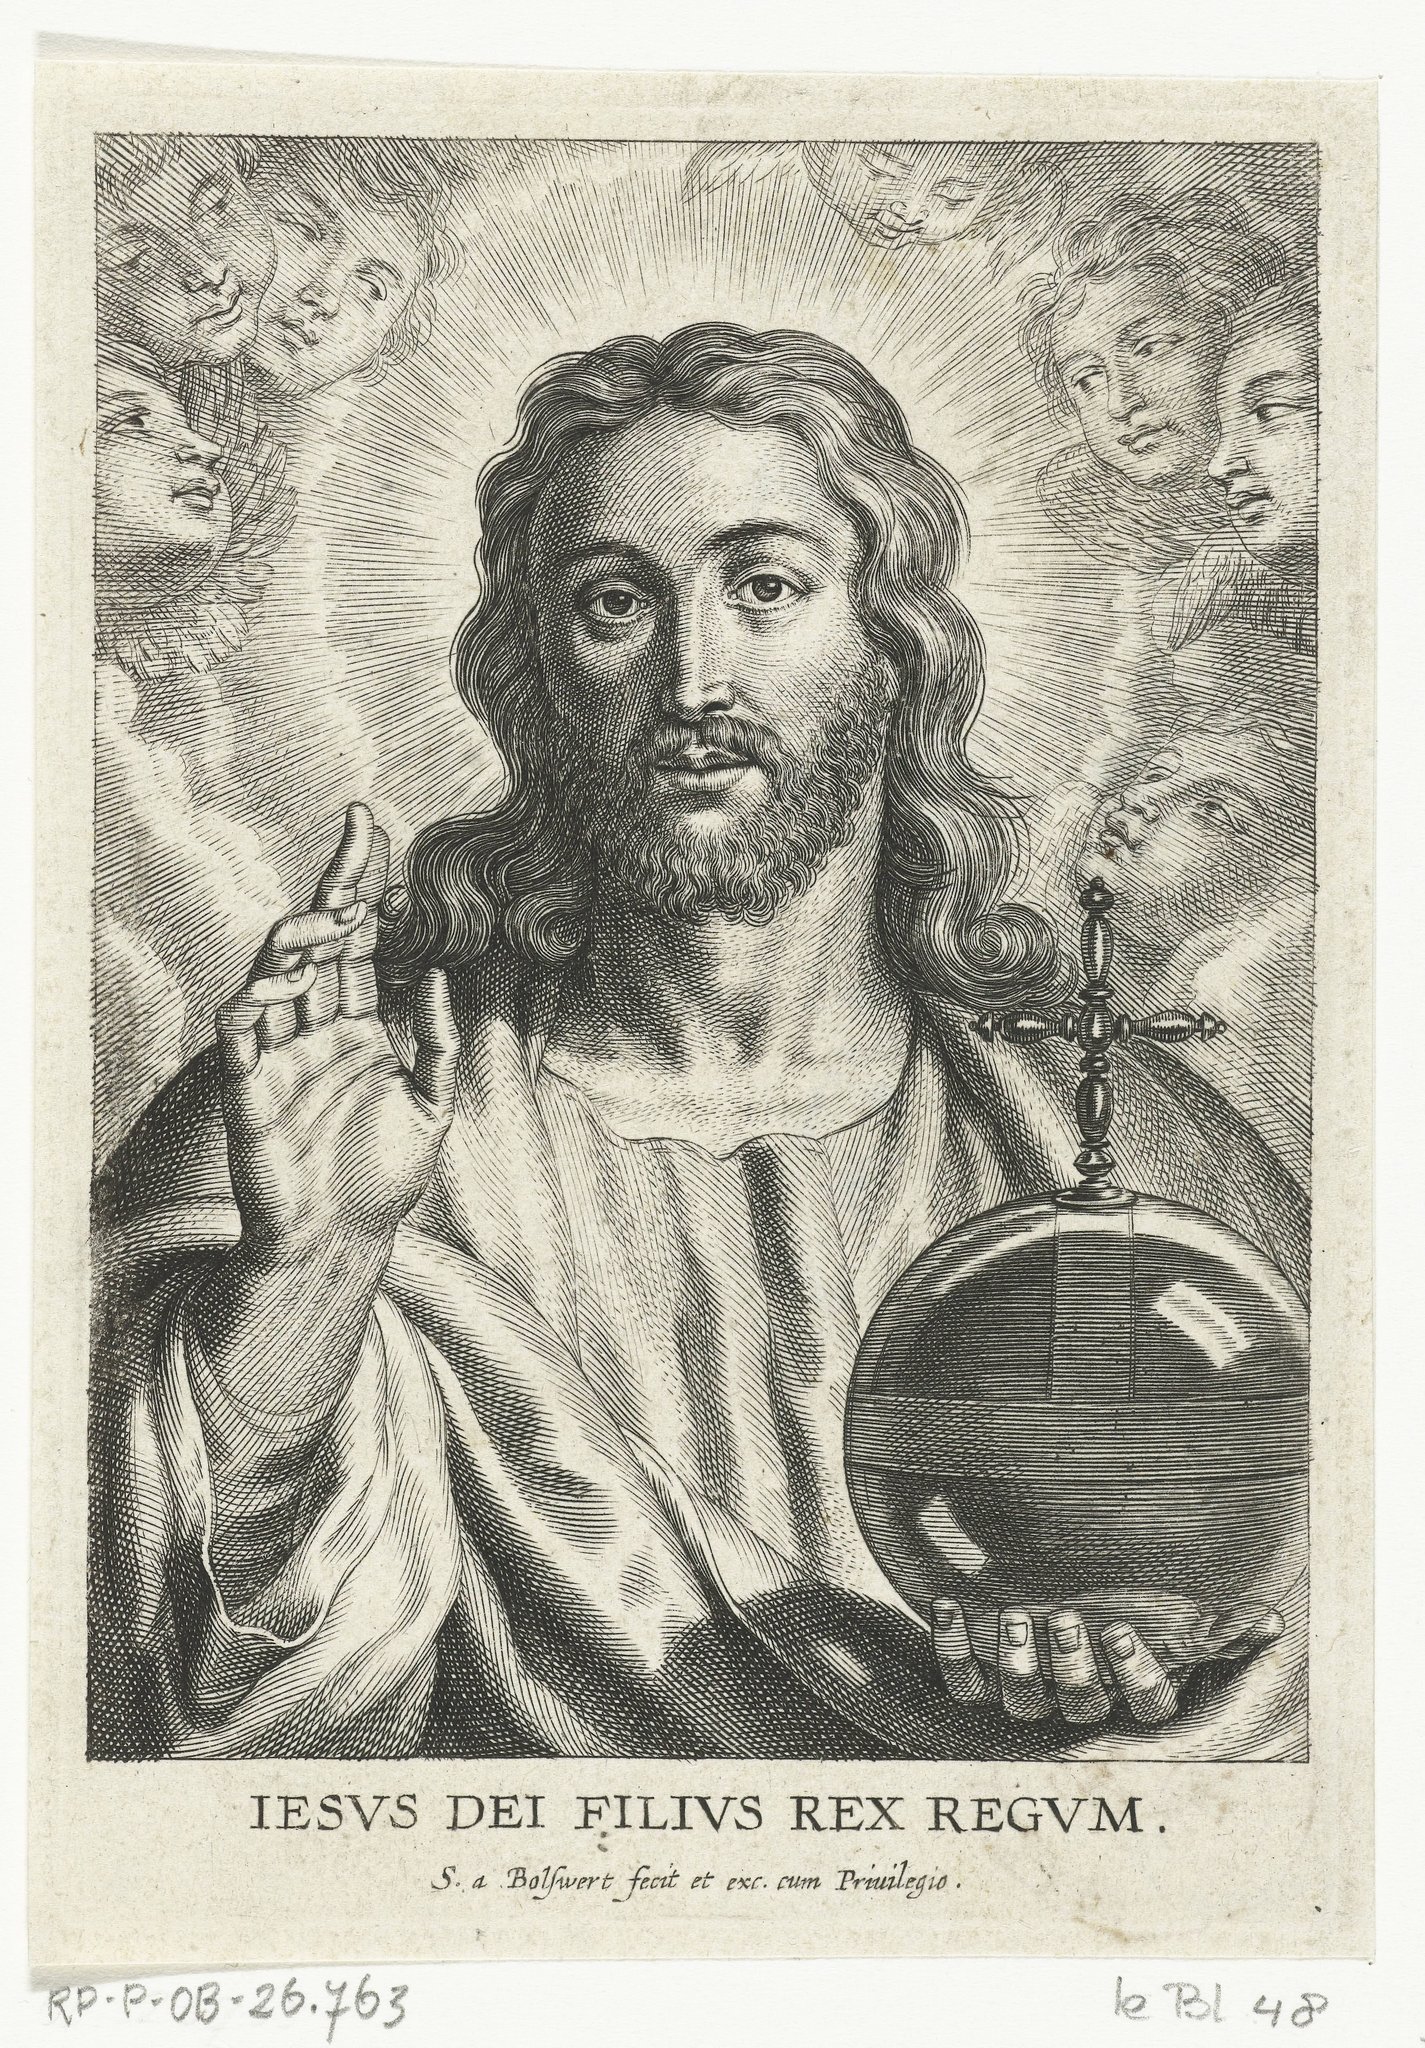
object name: print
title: Christus als Salvator Mundi met cherubijnen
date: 1596-1659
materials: paper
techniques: engraving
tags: 'salvator mundi', making a blessing gesture; an orb in his hand or at his feet (+ angel(s))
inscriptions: collector's mark: Lugt 240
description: Prent uit serie Vélins met negentig prenten naar ontwerp van Peter Paul Rubens. In de bronnen vinden we uiteenlopende gegevens over aantal en samenstelling van de serie. Hollstein hanteert het aantal van negentig prenten. De reeks Vélins in de collectie van het RMA bevat verschillende staten afkomstig uit meerdere uitgaven welke moeilijk te duiden zijn. Sommige dragen het originele adres van Schelte Adamsz. Bolswert als graveur en uitgever, op andere exemplaren is deze naam verwijderd (duidelijk zichtbaar!) en vervangen door de naam Cornelis Galle (II). De prenten met de naam van uitgever Galle zijn vaak opgewerkt. We treffen nog een andere naam van een uitgever bij enkele prent aan: Martien van den Enden. Herkomst uit meerdere uitgaven spreekt ook uit afwijkende opschriften in Nederlands en Latijn en variaties op dezelfde thema's welke misschien nooit langs elkaar in dezelfde serie gebruikt werden.